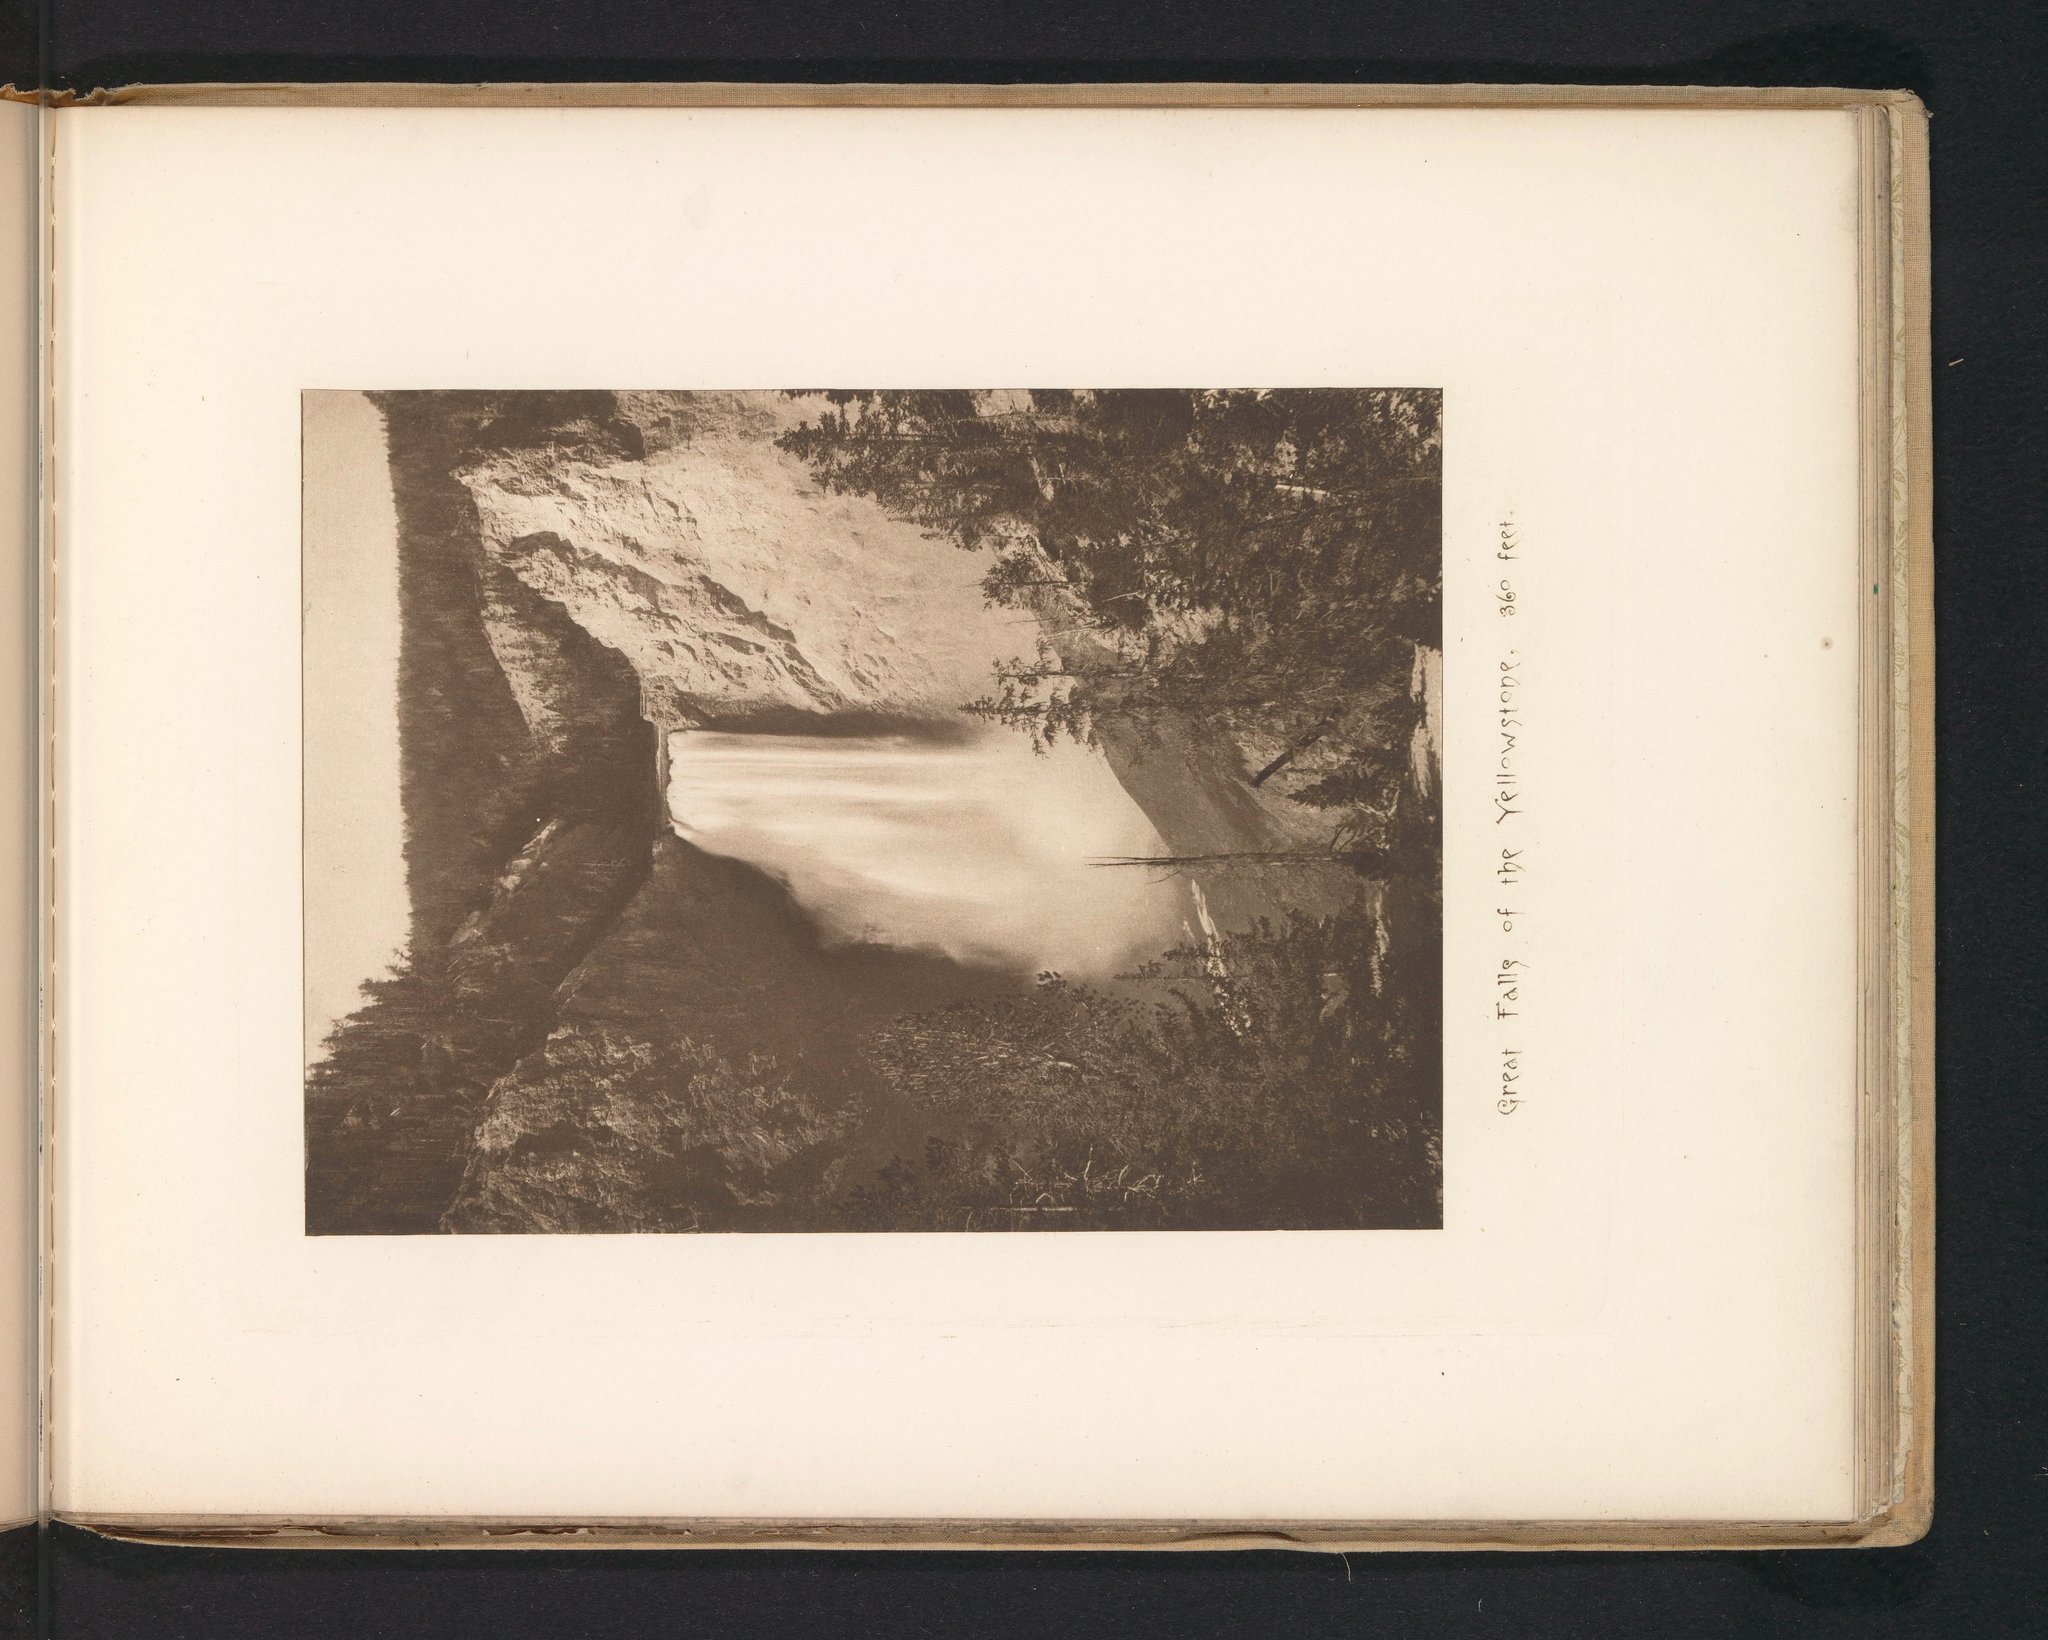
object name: photomechanical print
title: Great Falls of the Yellowstone, 360 feet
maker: frank jay haynes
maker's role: fotograaf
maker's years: 1853-1921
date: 1882-1887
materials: paper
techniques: photoaquatint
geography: yellowstone national park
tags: waterfall